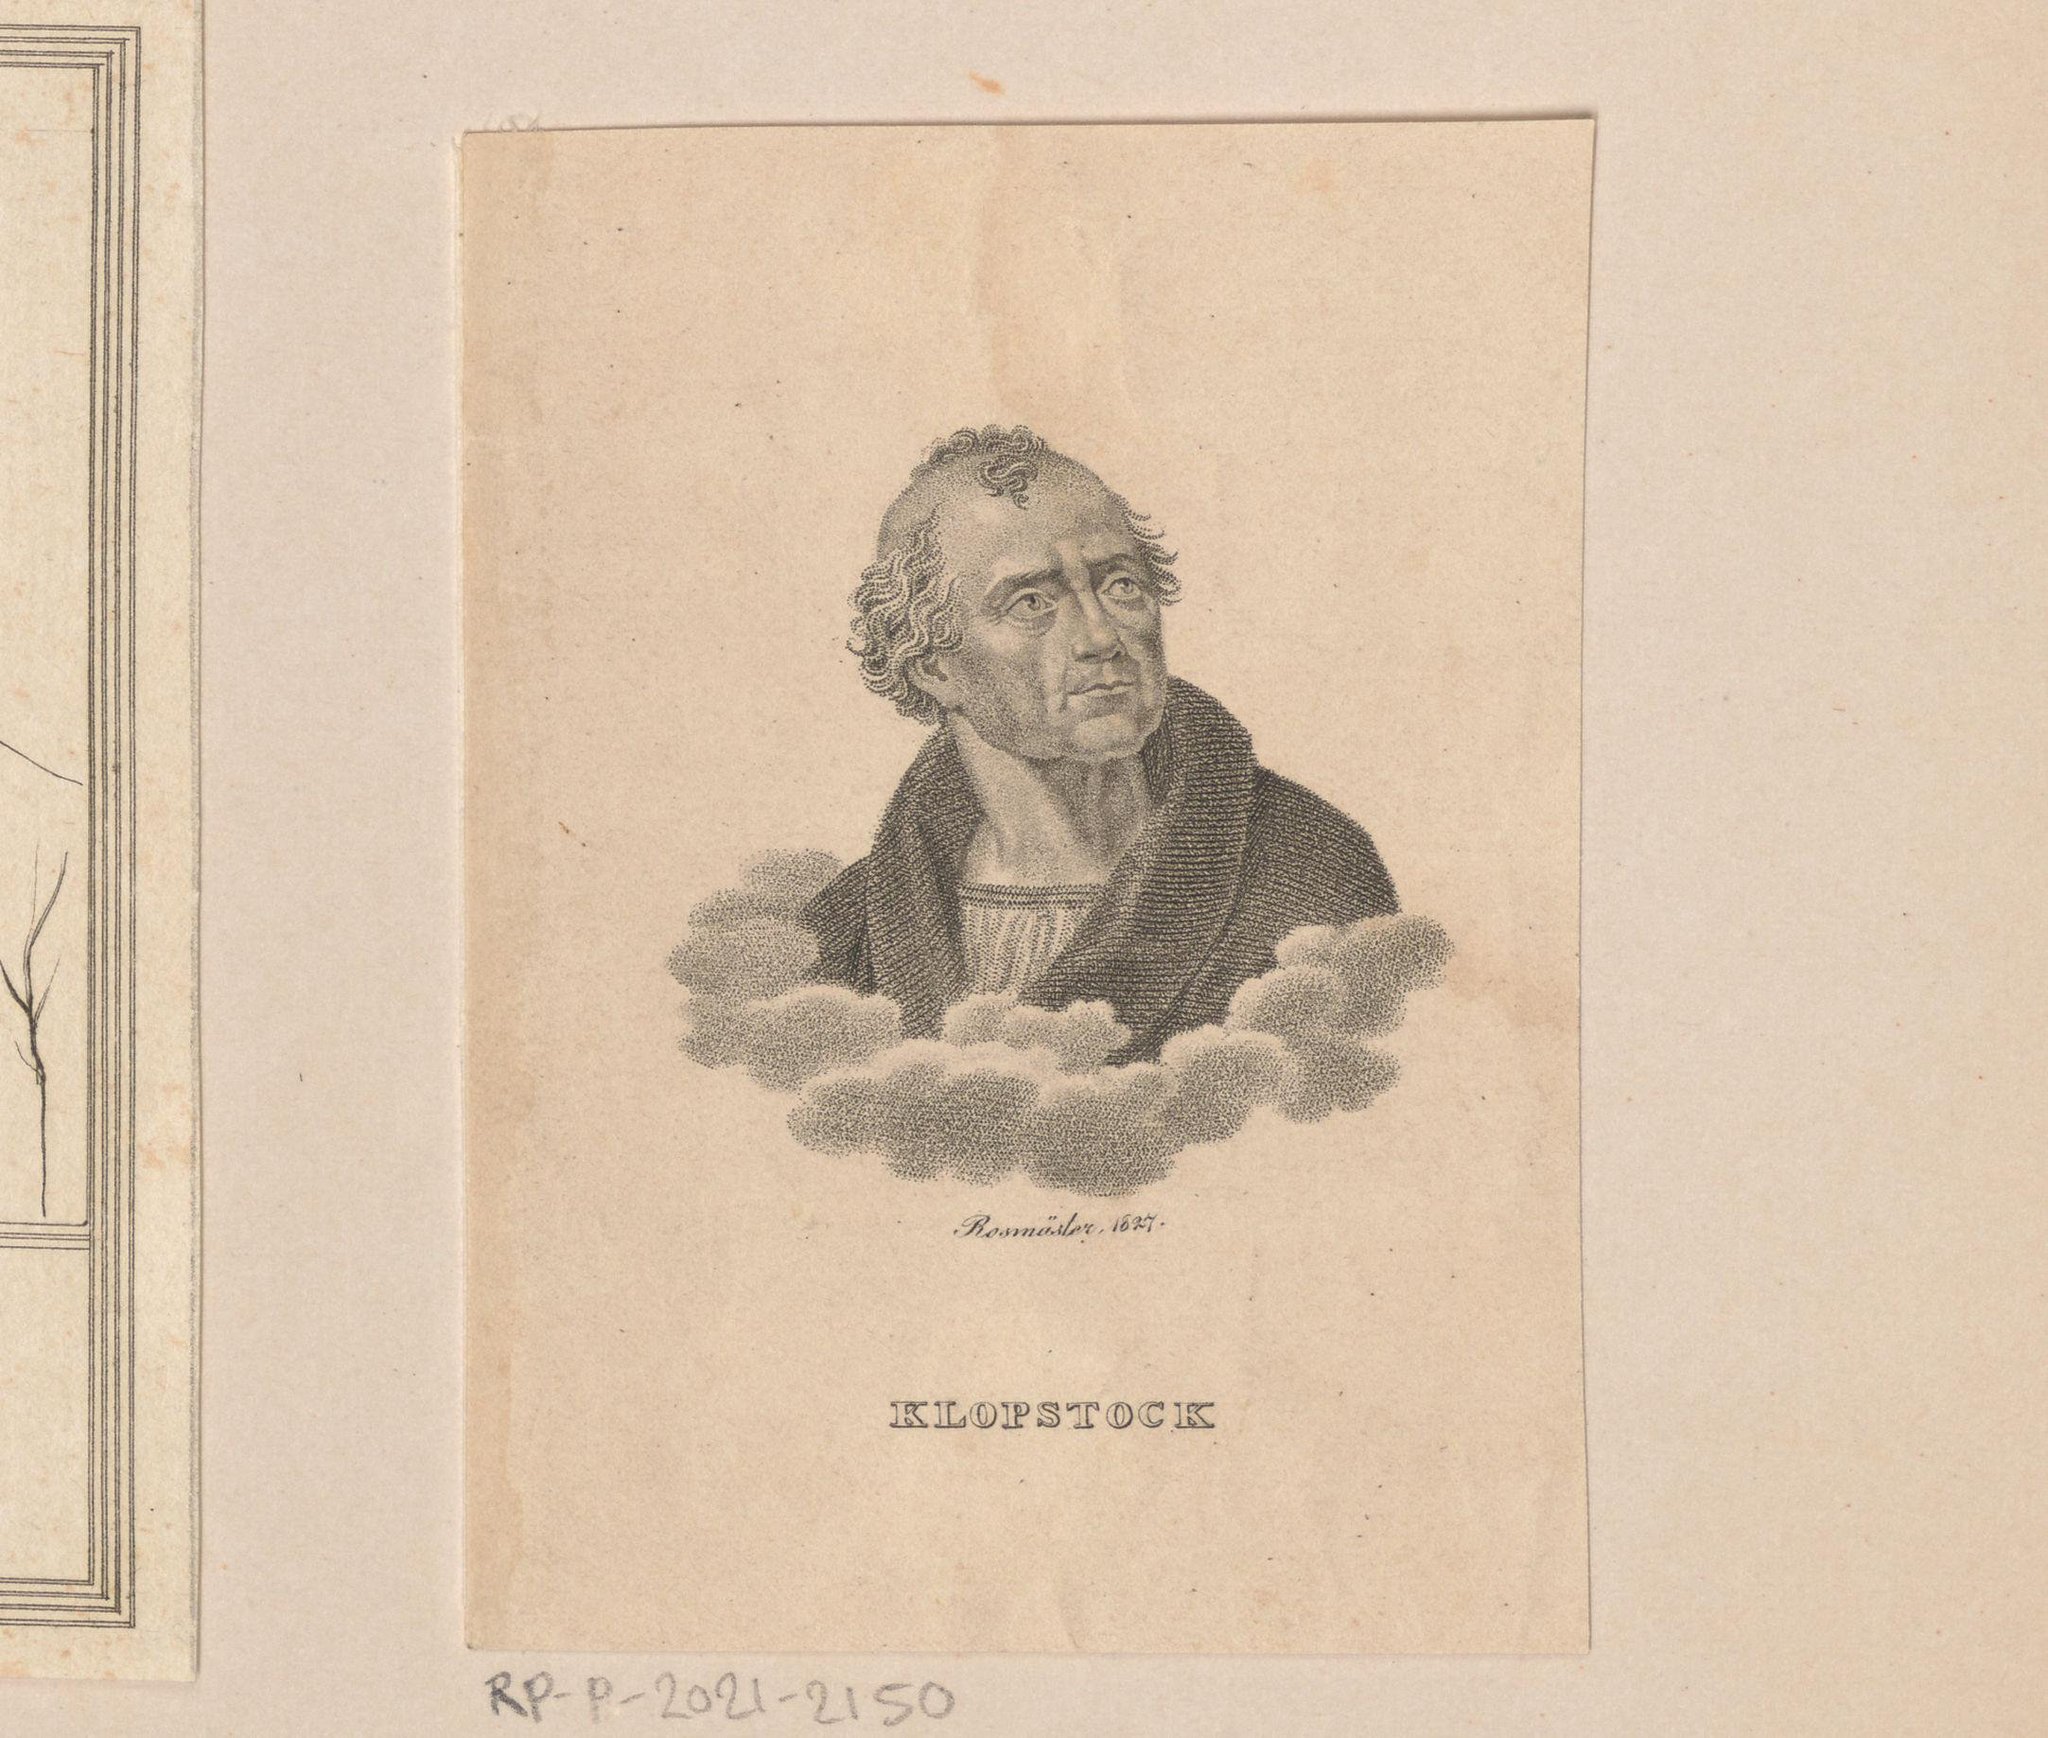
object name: print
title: Portret van Friedrich Gottlieb Klopstock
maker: friedrich rossmässler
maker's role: print maker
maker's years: 1775-1858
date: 1827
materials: paper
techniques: engraving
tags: clouds, historical persons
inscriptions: date